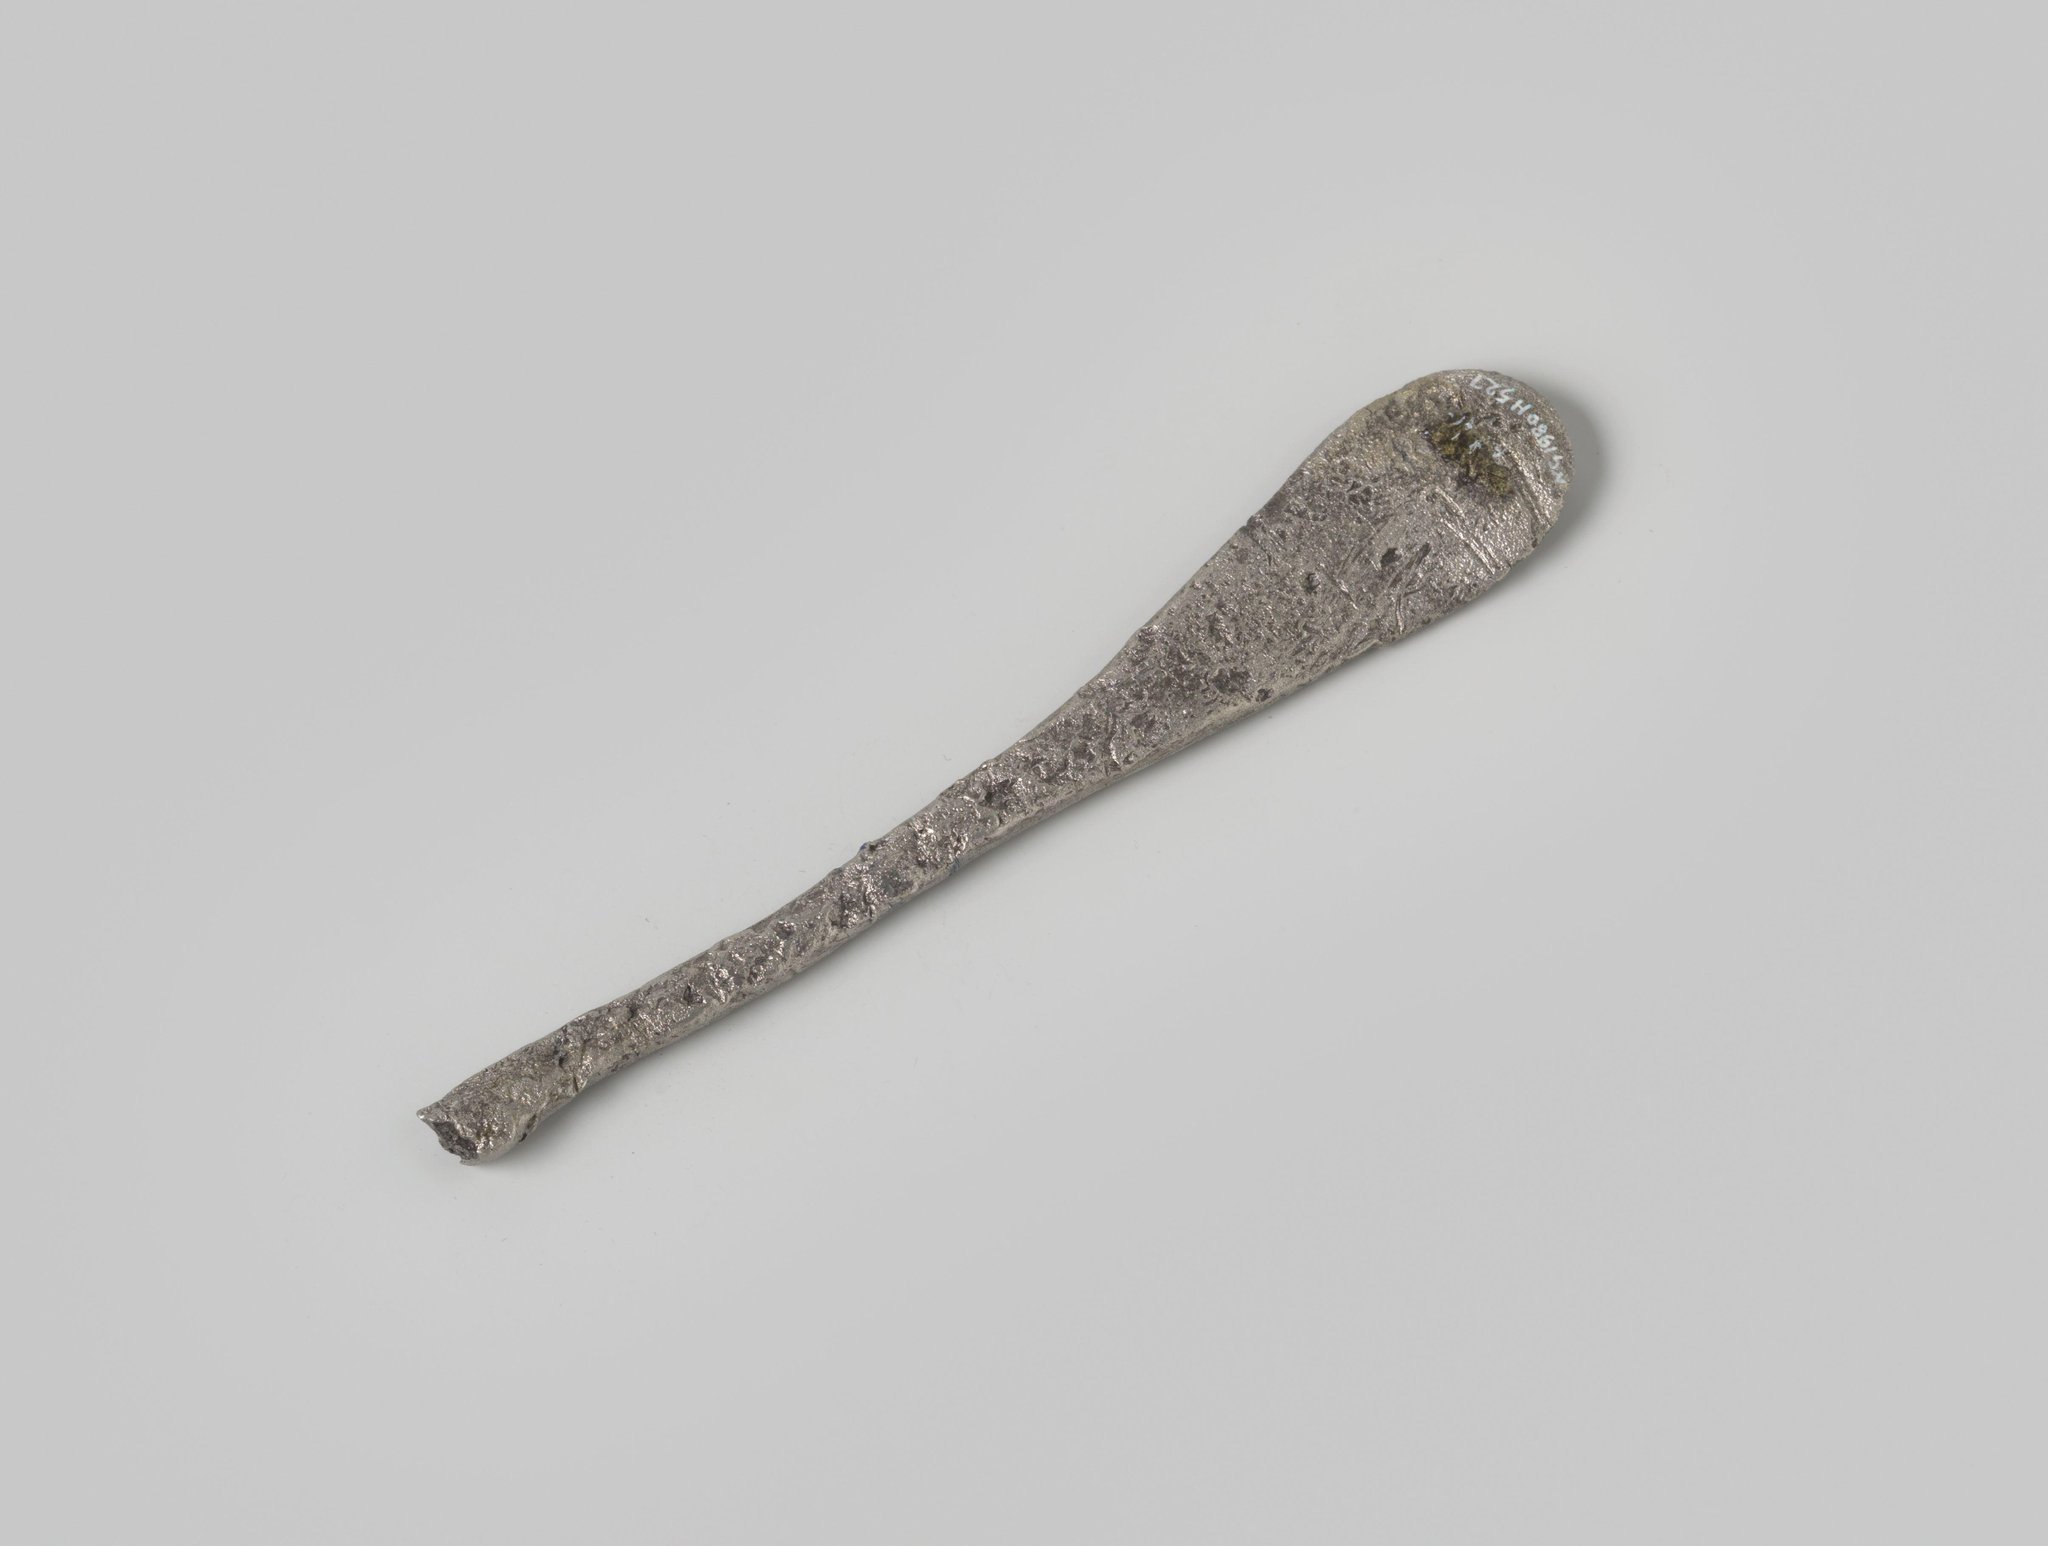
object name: spoon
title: Steel van een lepel uit het wrak van de Oost-Indiëvaarder Hollandia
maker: Anonymous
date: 1700-1743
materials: tin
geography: netherlands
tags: verenigde oostindische compagnie, hollandia (schip), annet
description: Cutlery, spoon; fragment, stem, hexagonal-section, widening towards cu rved end, on upper side central ridge and relieved inscription [AVOC], ass. NG 1980-27H1165.